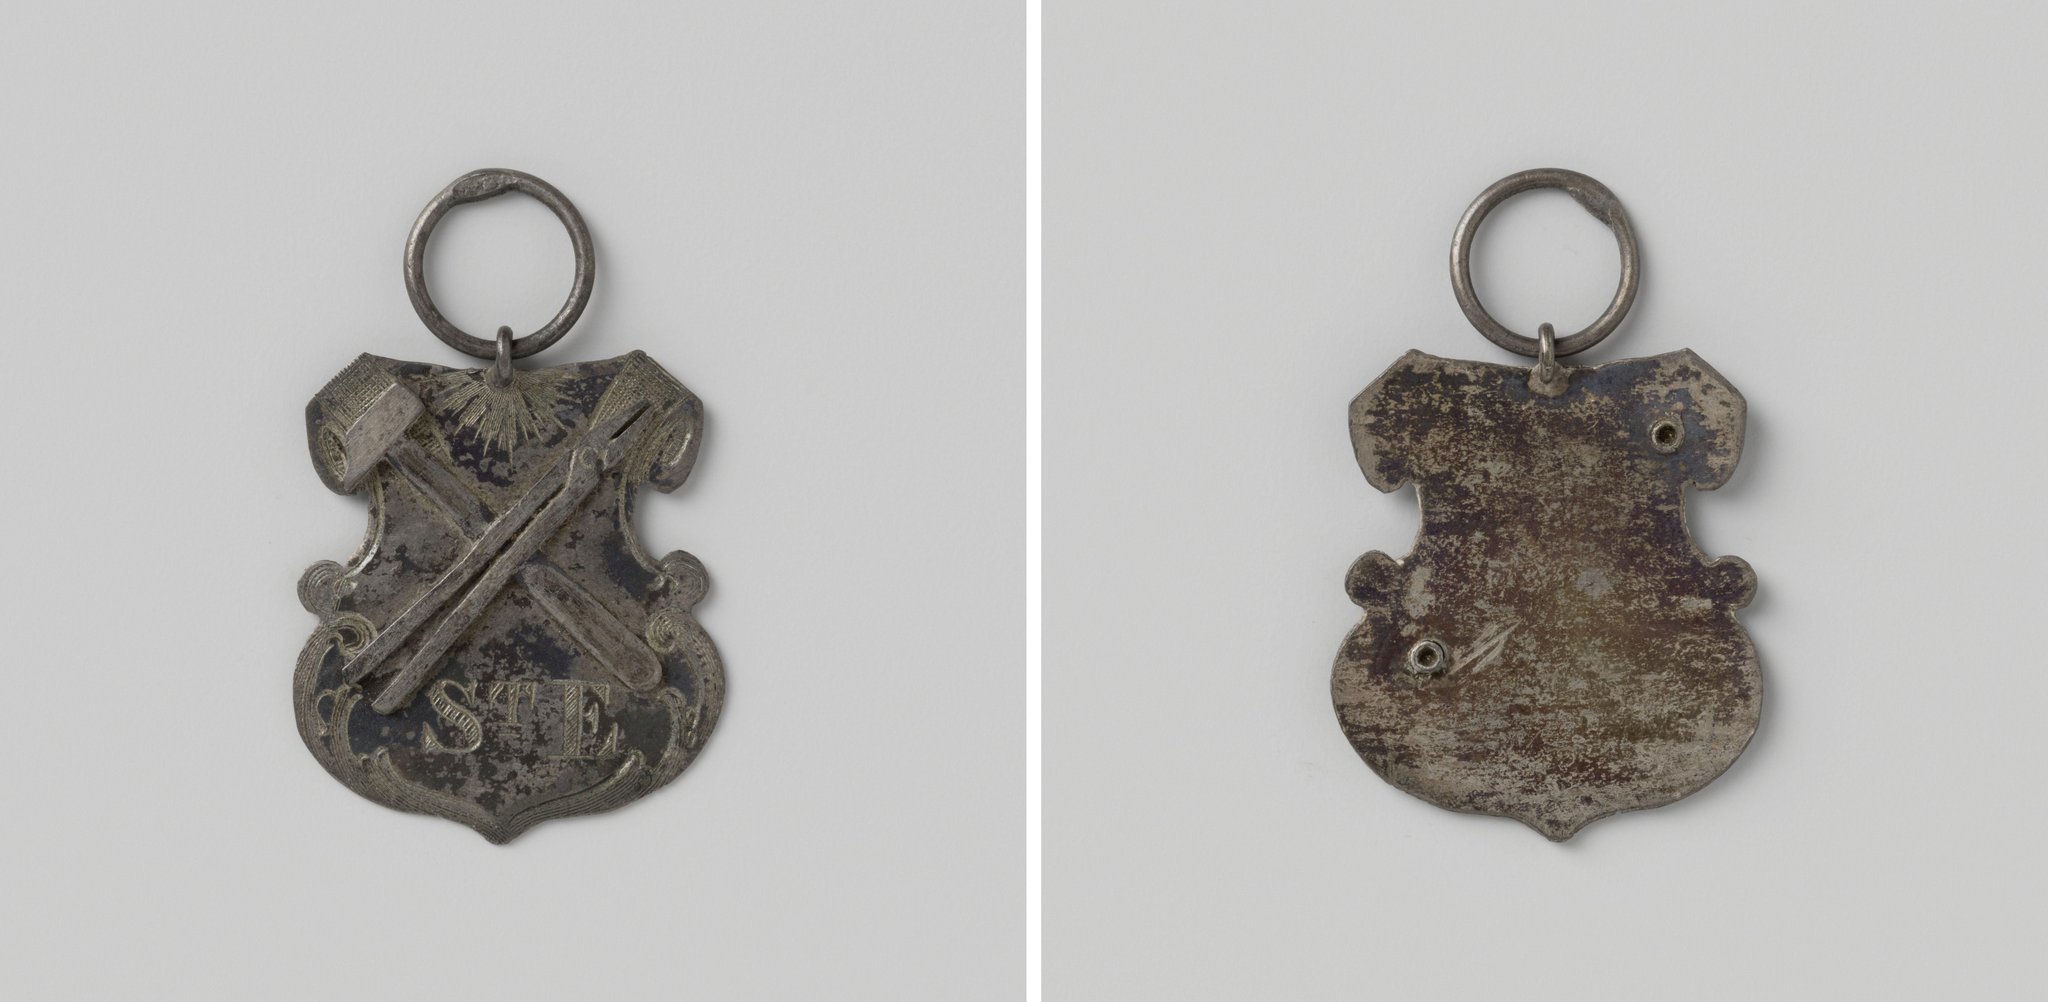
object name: insignia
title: Draagteken van het Sint Eloy- of Smedengilde van een onbekende plaats.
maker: Anonymous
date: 1700-1850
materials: silver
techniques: striking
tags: noyon, eligius van noyon (elooi)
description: Eenzijdig zilveren draagteken in vorm van schild aan draagoog en ring. Voorzijde: gekruiste hamer en tang boven opschrift St E.